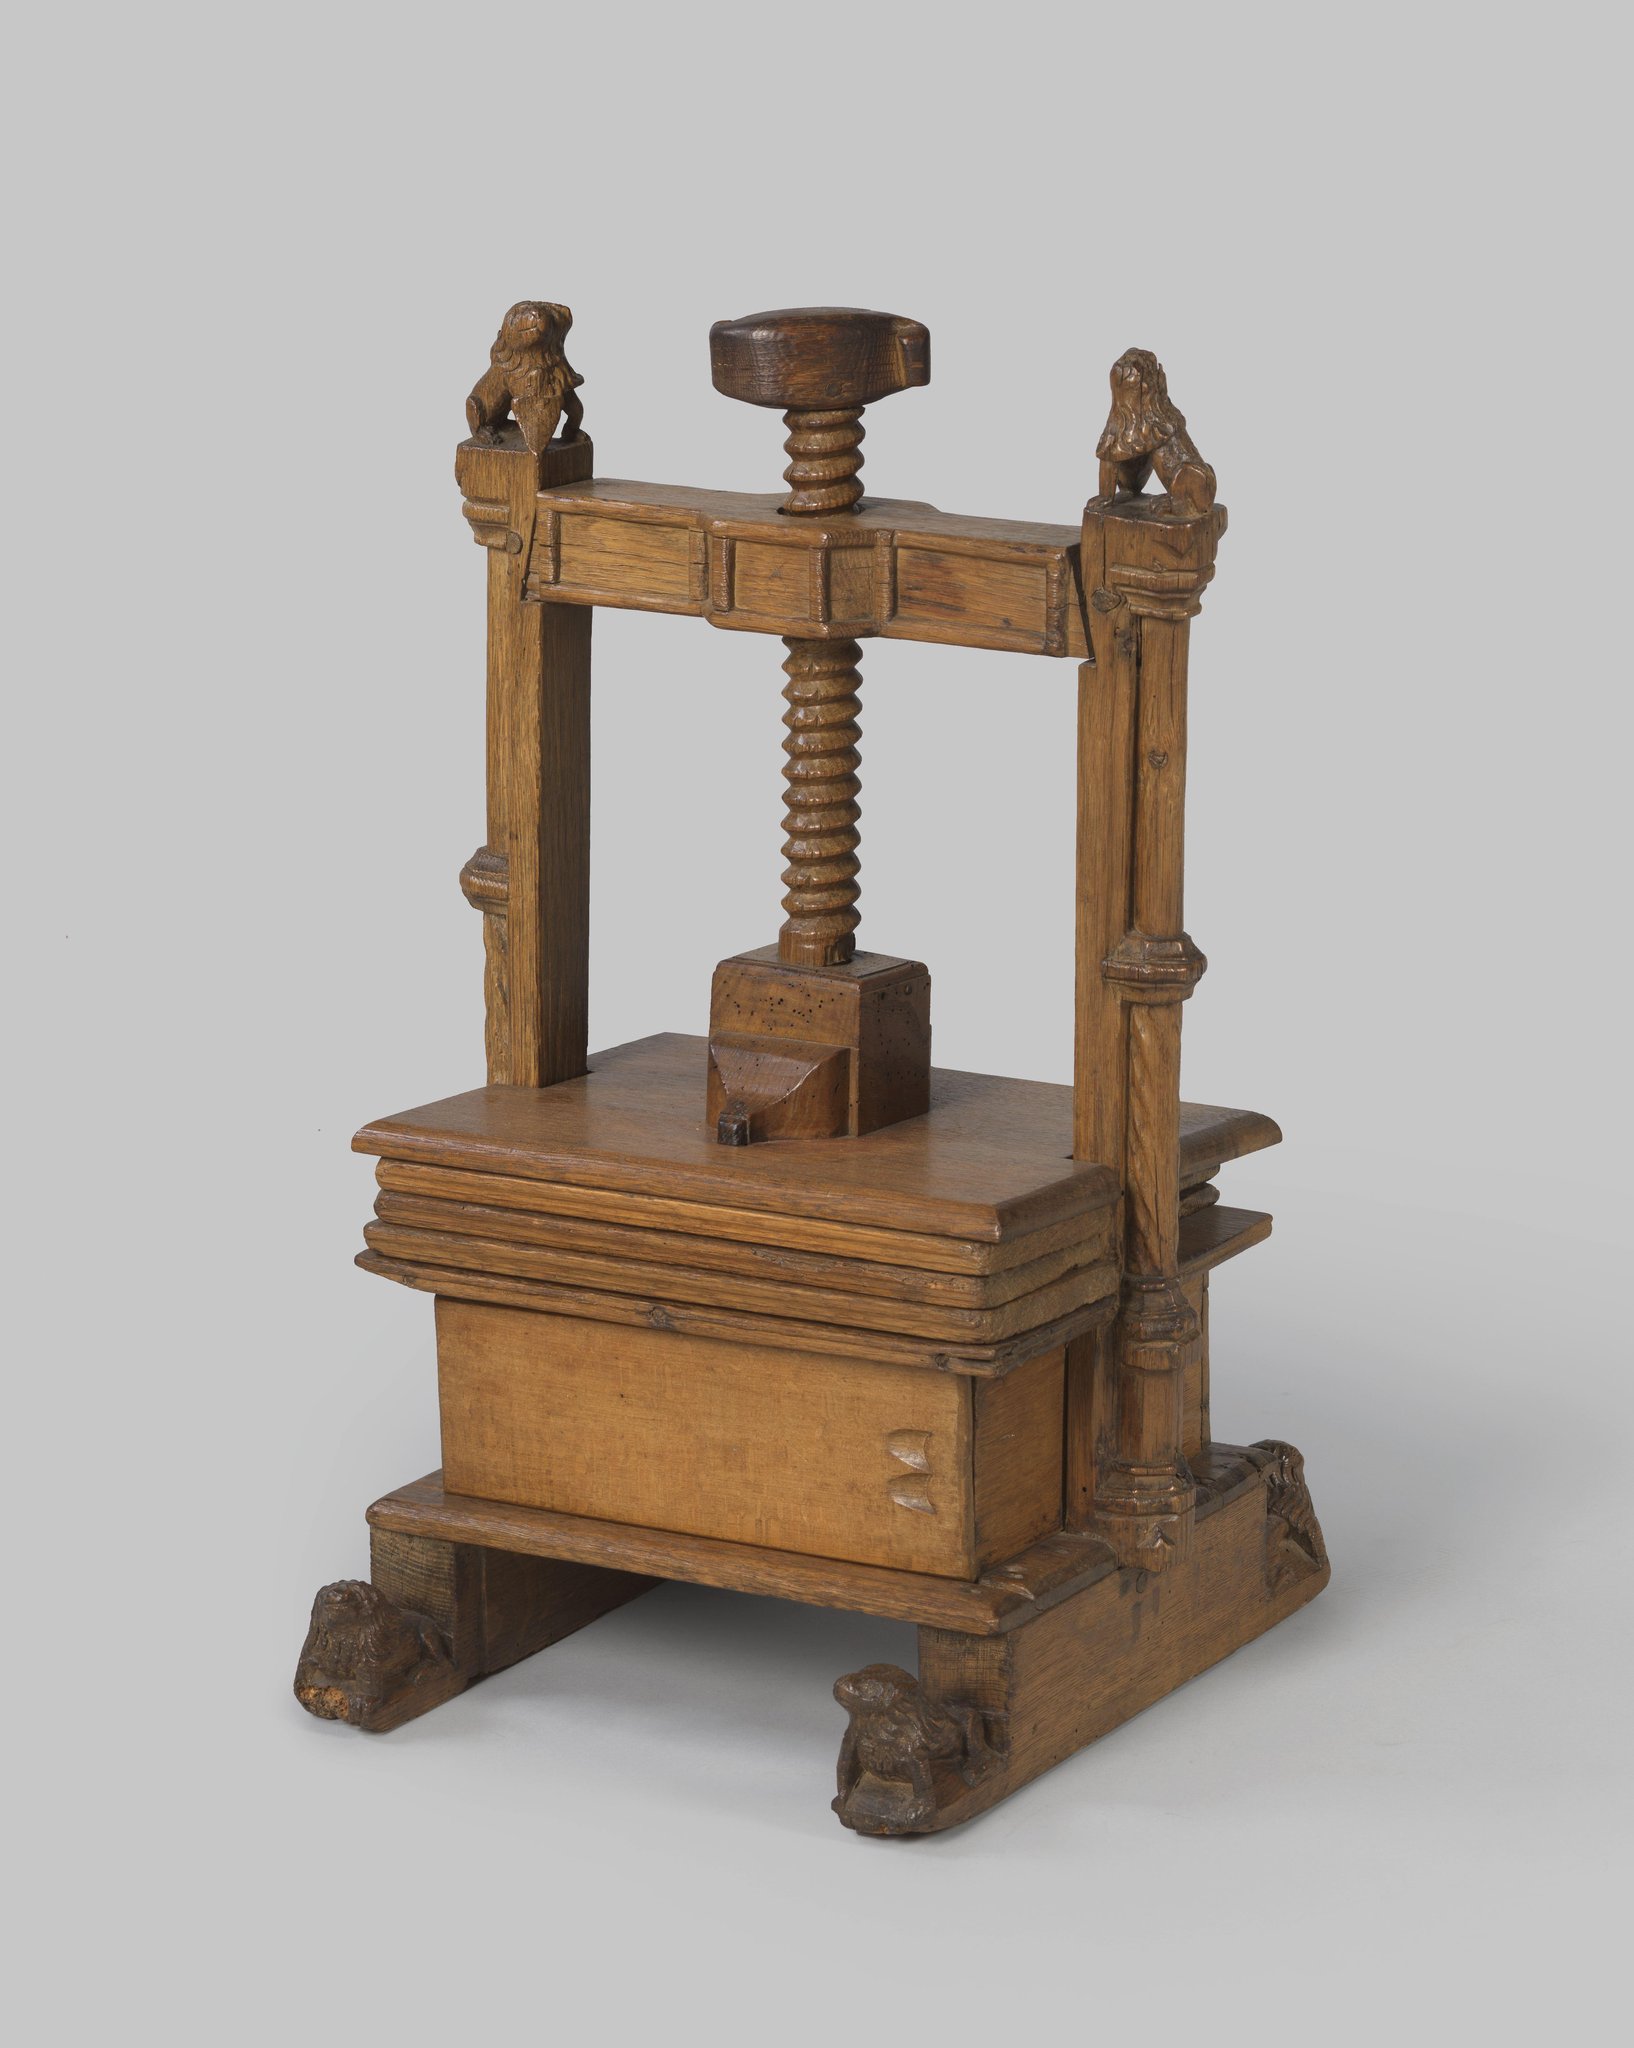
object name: furniture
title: Handpers op sleeppoten die eindigen in liggende leeuwen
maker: Anonymous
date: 1500-1515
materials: wood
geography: low countries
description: Hand press. Oak. Netherlands, c. 1500 - 1520.